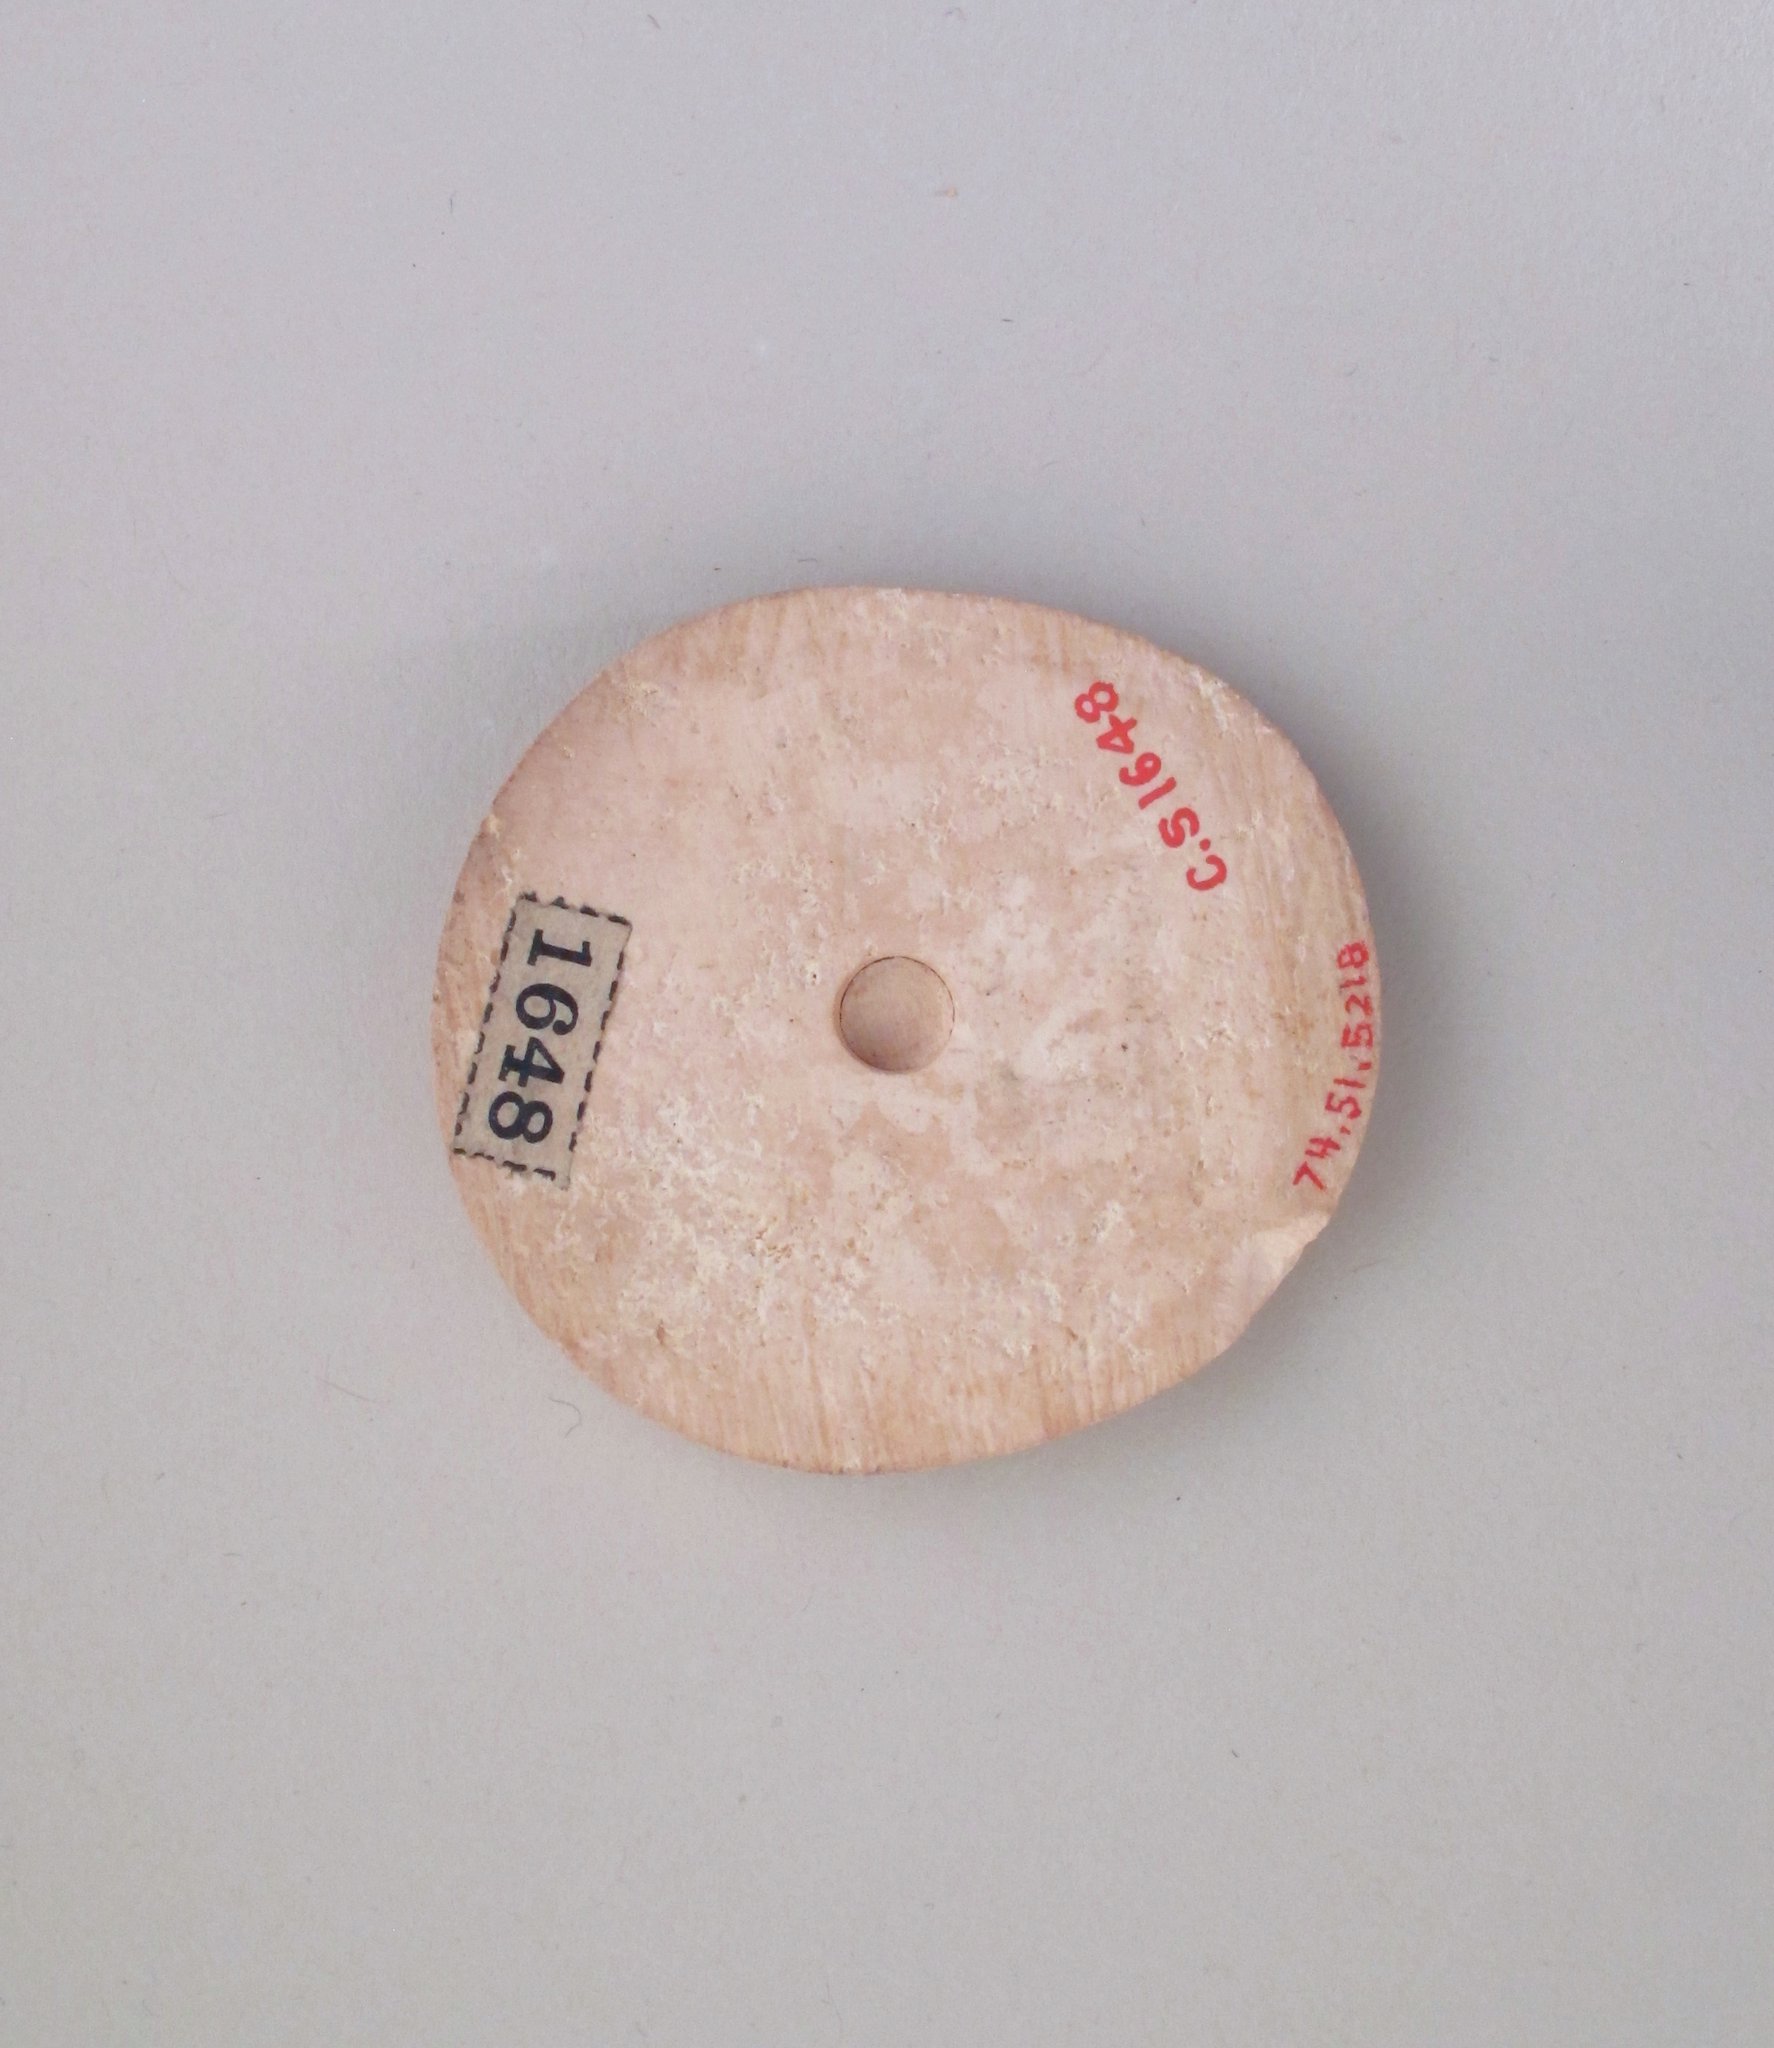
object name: roundel, disk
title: Ivory disk of a pyxis with rosette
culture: cypriot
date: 1300-1101 BCE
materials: ivory